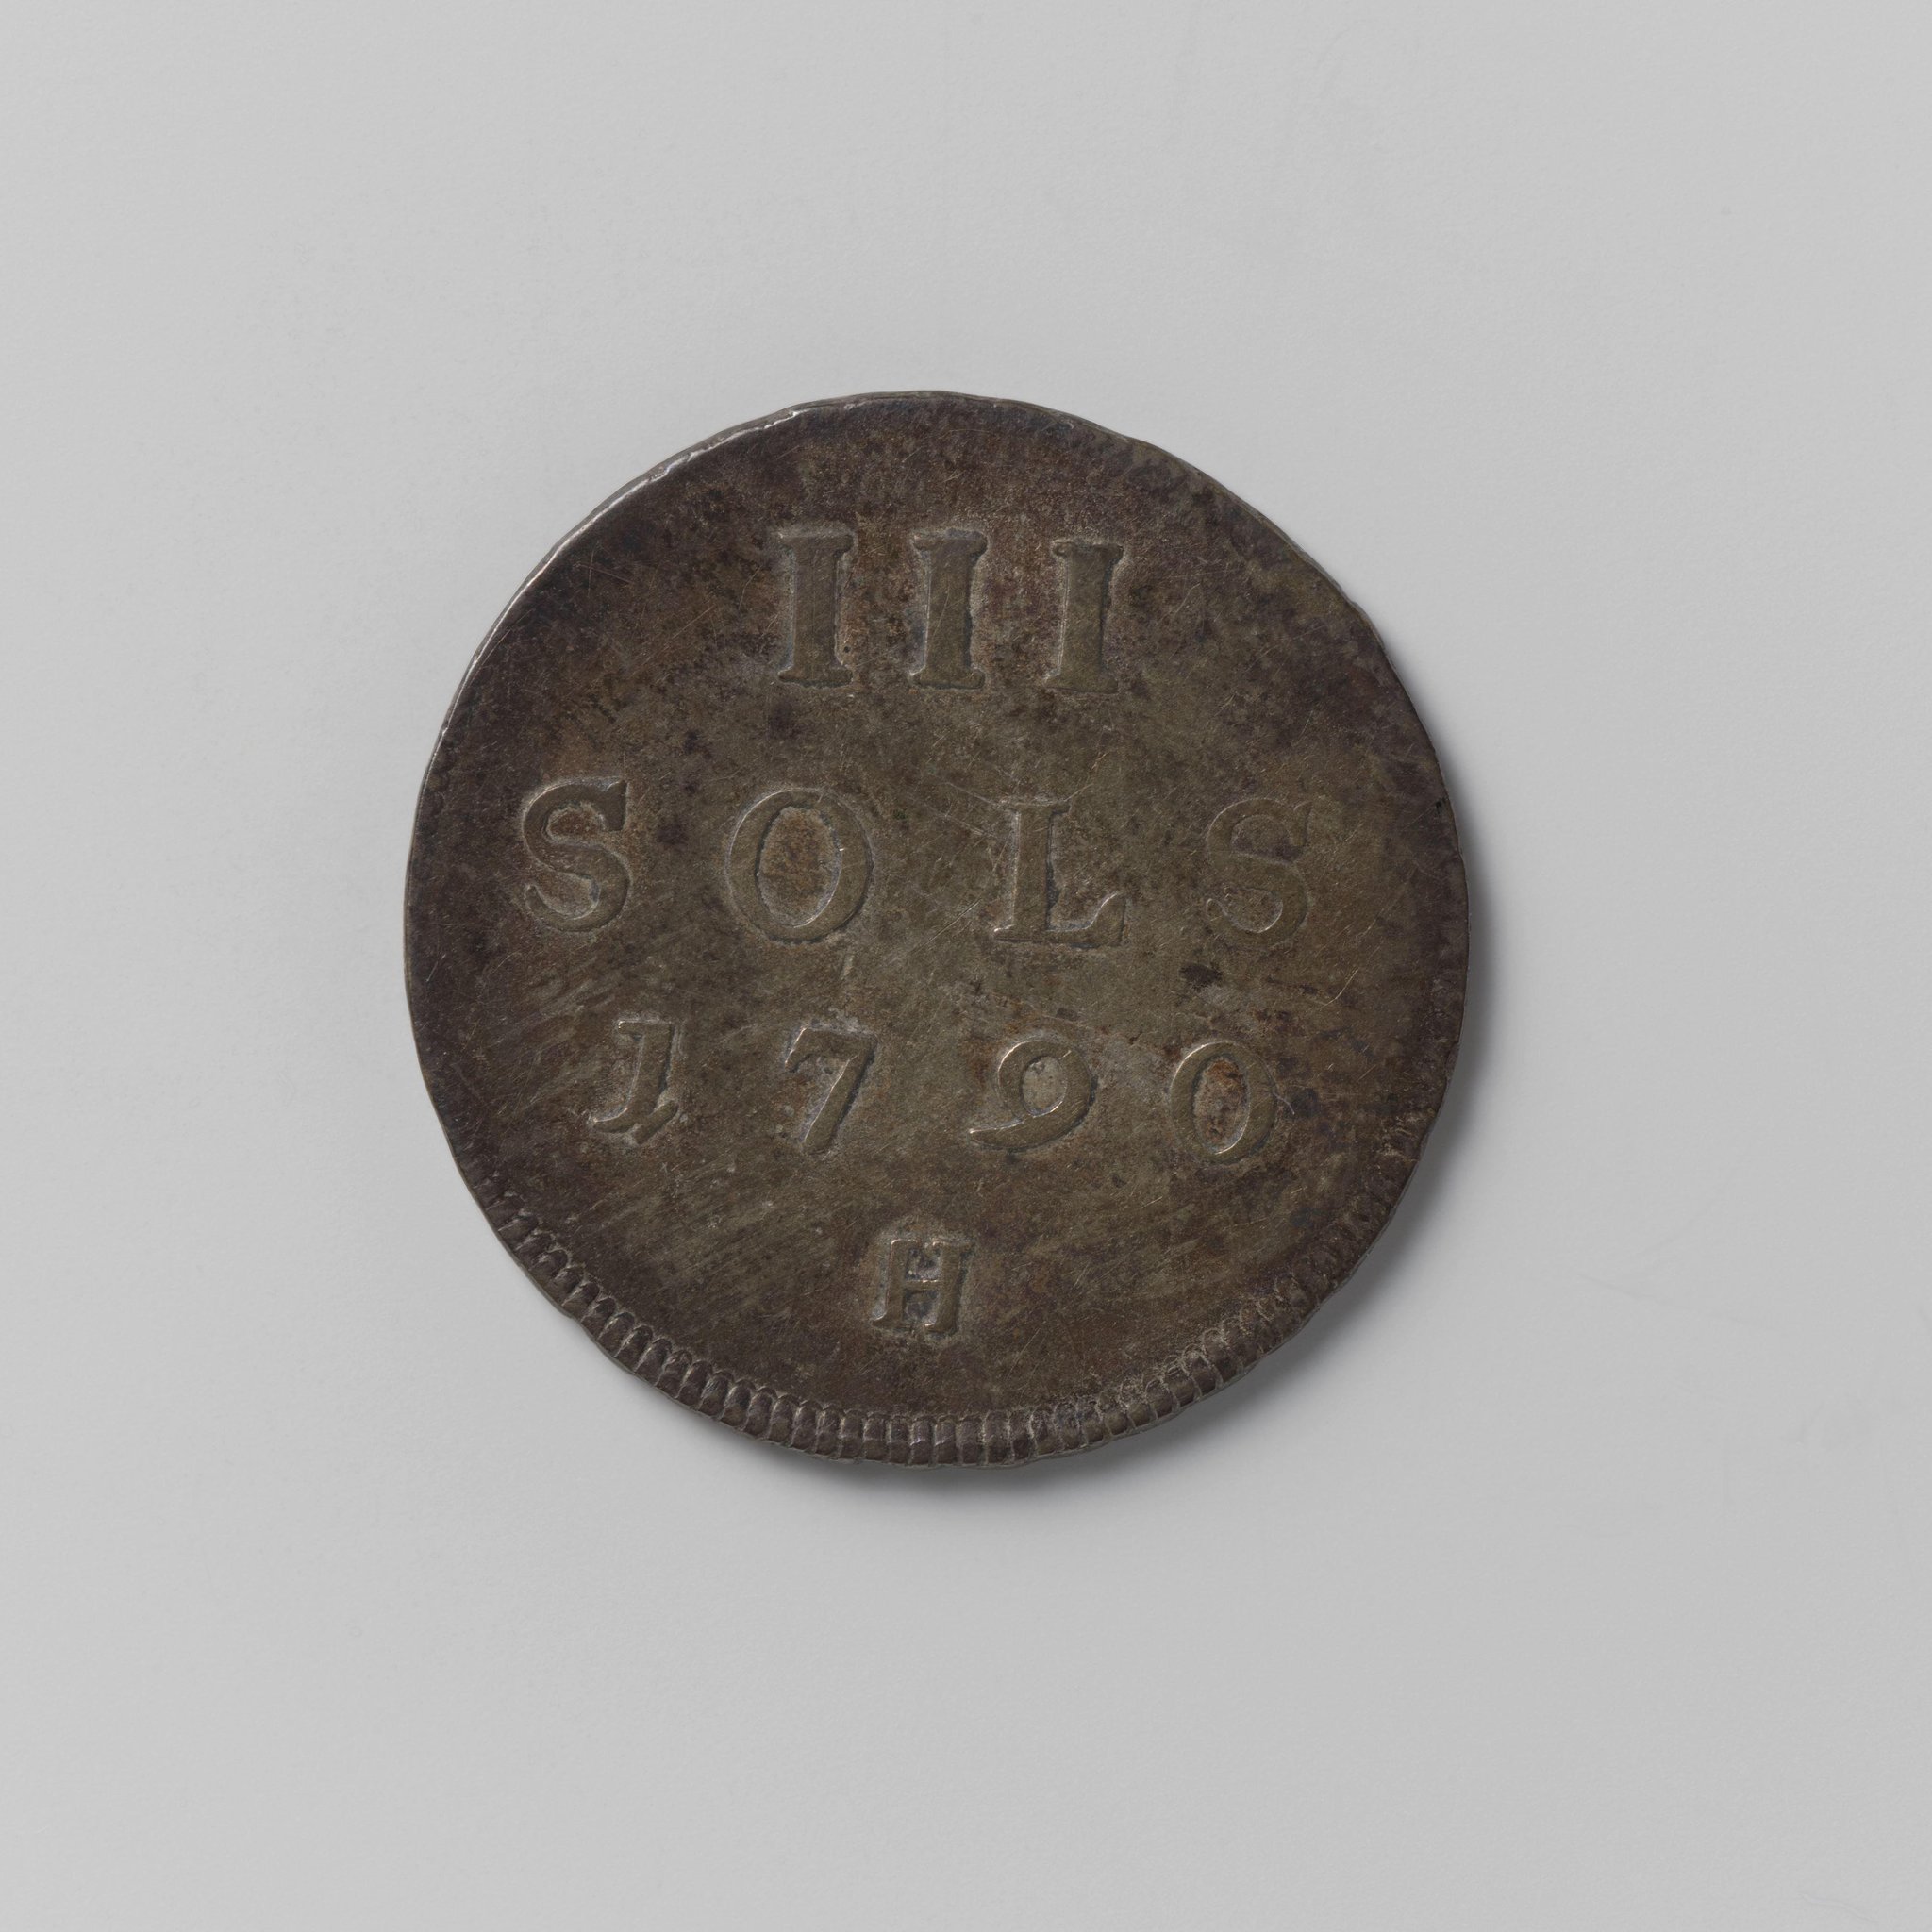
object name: coin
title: Luxemburg, Jozef II, 3 sols [sous] of 3 stuiver, 1790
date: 1790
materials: silver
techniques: striking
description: Zilveren munt. Voorzijde: gekroond wapenschild. Keerzijde: in twee regels waarde-aanduiding, waaronder jaartal. Daaronder letter H van muntplaats Günzburg. Bloemrand.